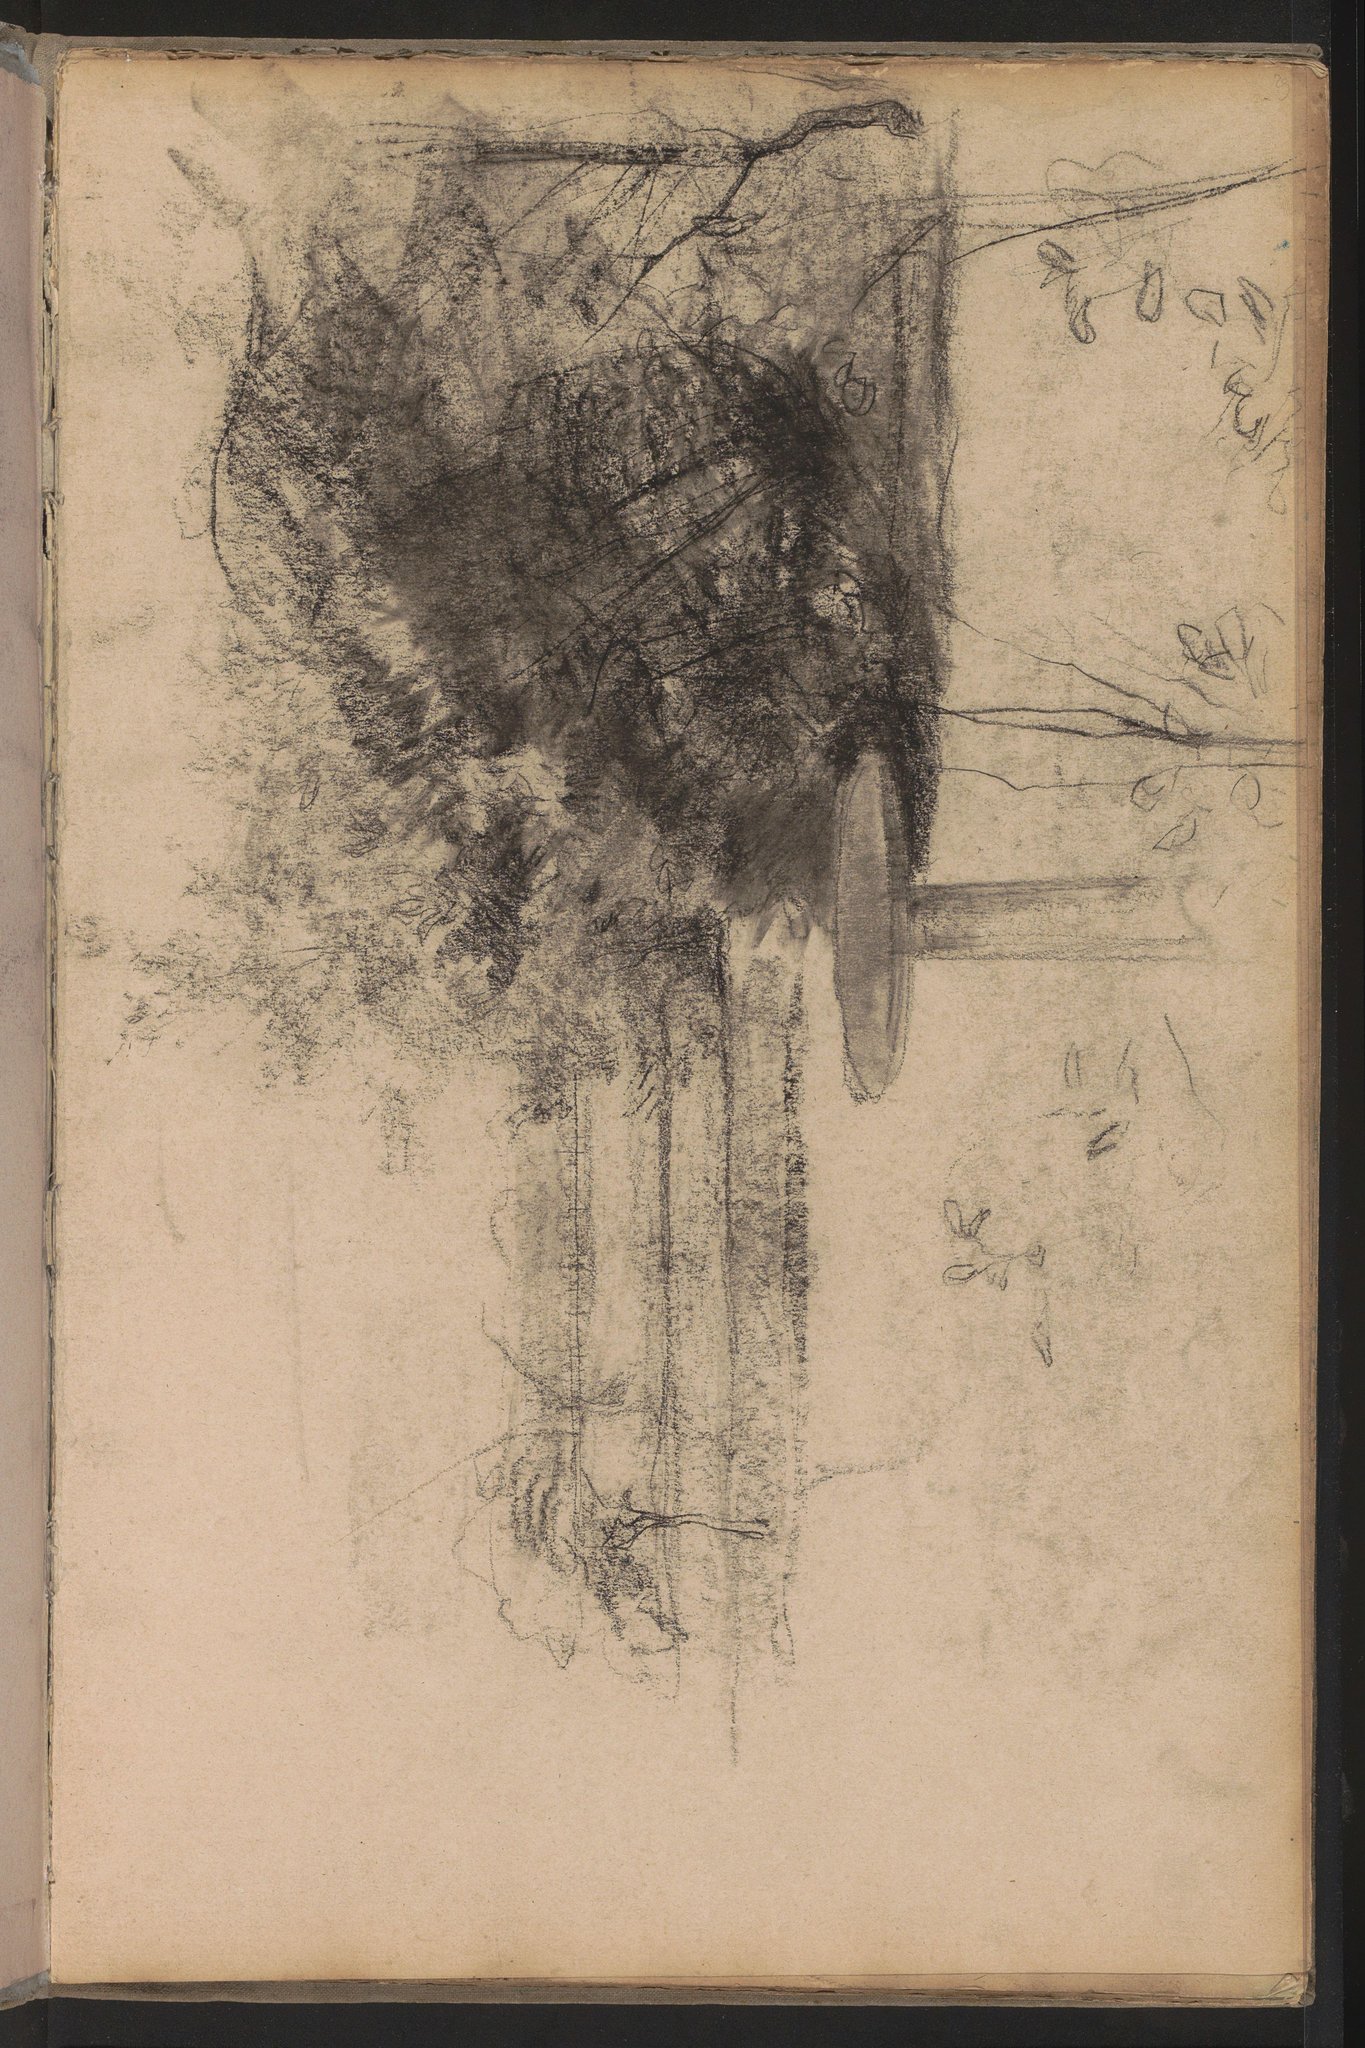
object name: sketchbook leaf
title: Landschap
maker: willem witsen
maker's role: draughtsman, painter, print maker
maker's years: 1860-1923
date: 1884-1887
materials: chalk, paper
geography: ewijkshoeve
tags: landscapes in the temperate zone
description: Pagina 29 uit een schetsboek met 45 bladen vervaardigd rond de Ewijkshoeve.